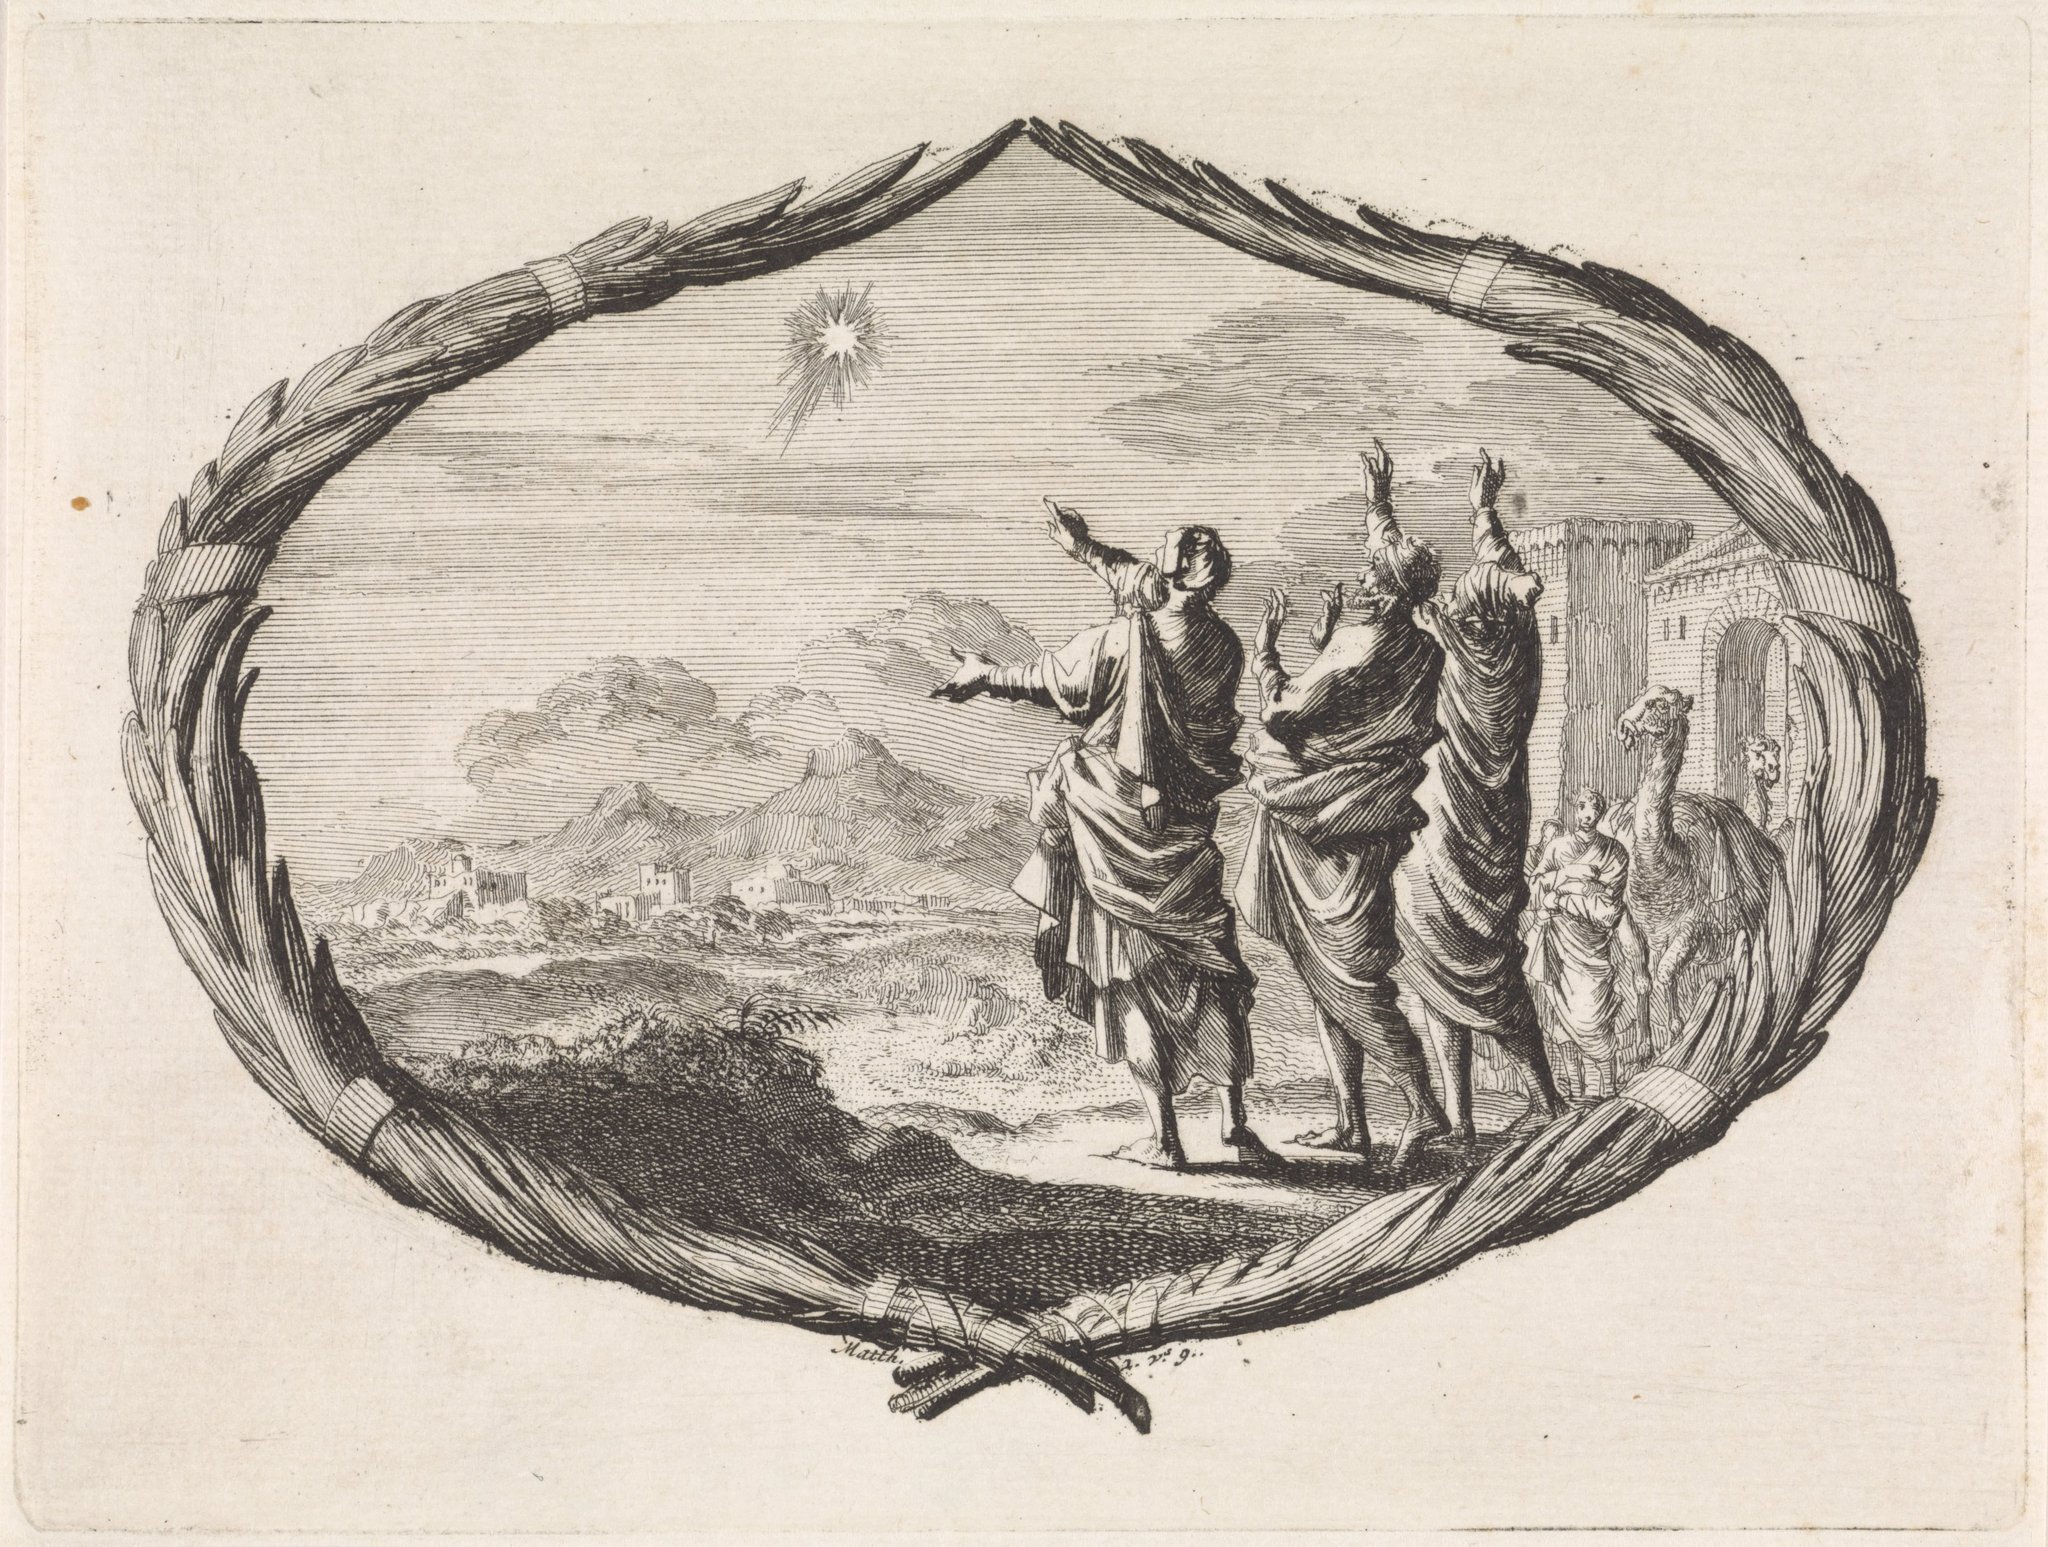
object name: print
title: Drie koningen zien de ster aan de hemel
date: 1700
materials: paper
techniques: etching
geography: amsterdam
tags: ornament ~ cartouche, the three wise men see a star and are astonished by its magnitude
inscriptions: collector's mark: Lugt 2228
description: Waarschijnlijk boekillustratie voor David Martin. Historie des Ouden en Nieuwen Testaments, verrykt met meer dan vierhonderd printverbeeldingen. Deel II. Amsterdam: Pieter Mortier, 1700, p. 37.